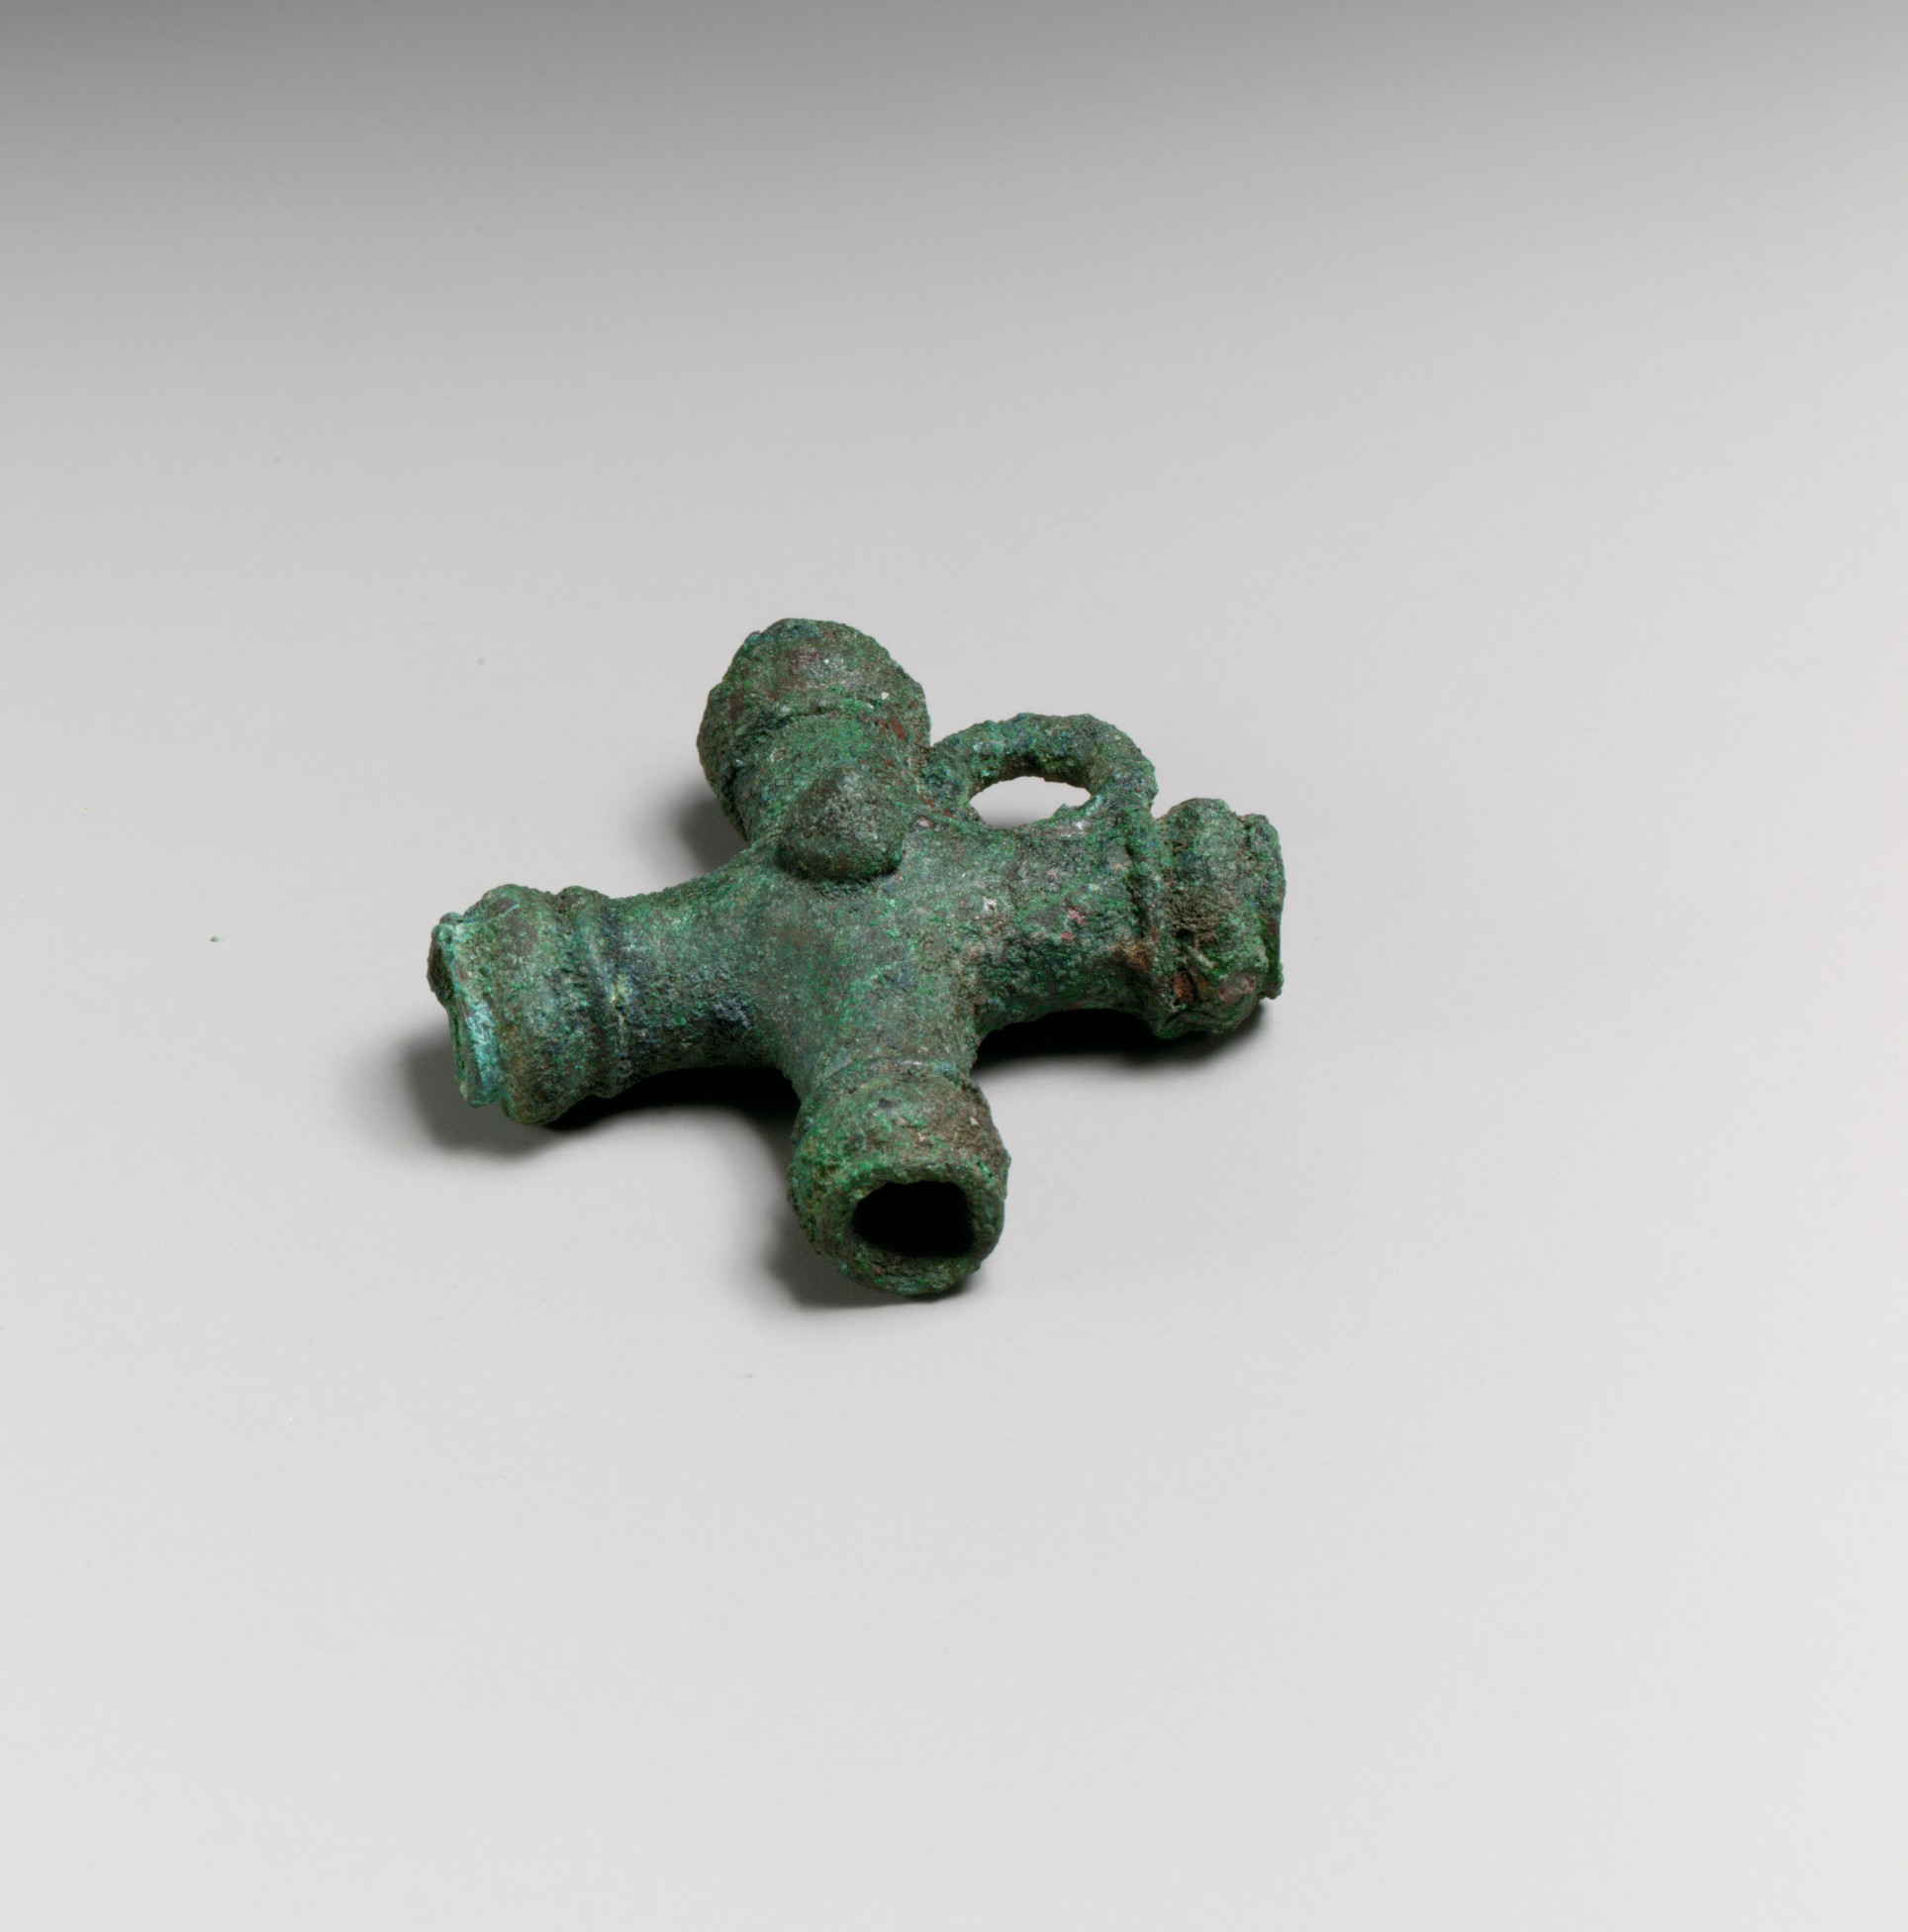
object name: chariot fragment, crossed cylinder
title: Fragments of a cart or chariot, crossed cylinders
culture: etruscan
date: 500-480 BCE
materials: bronze